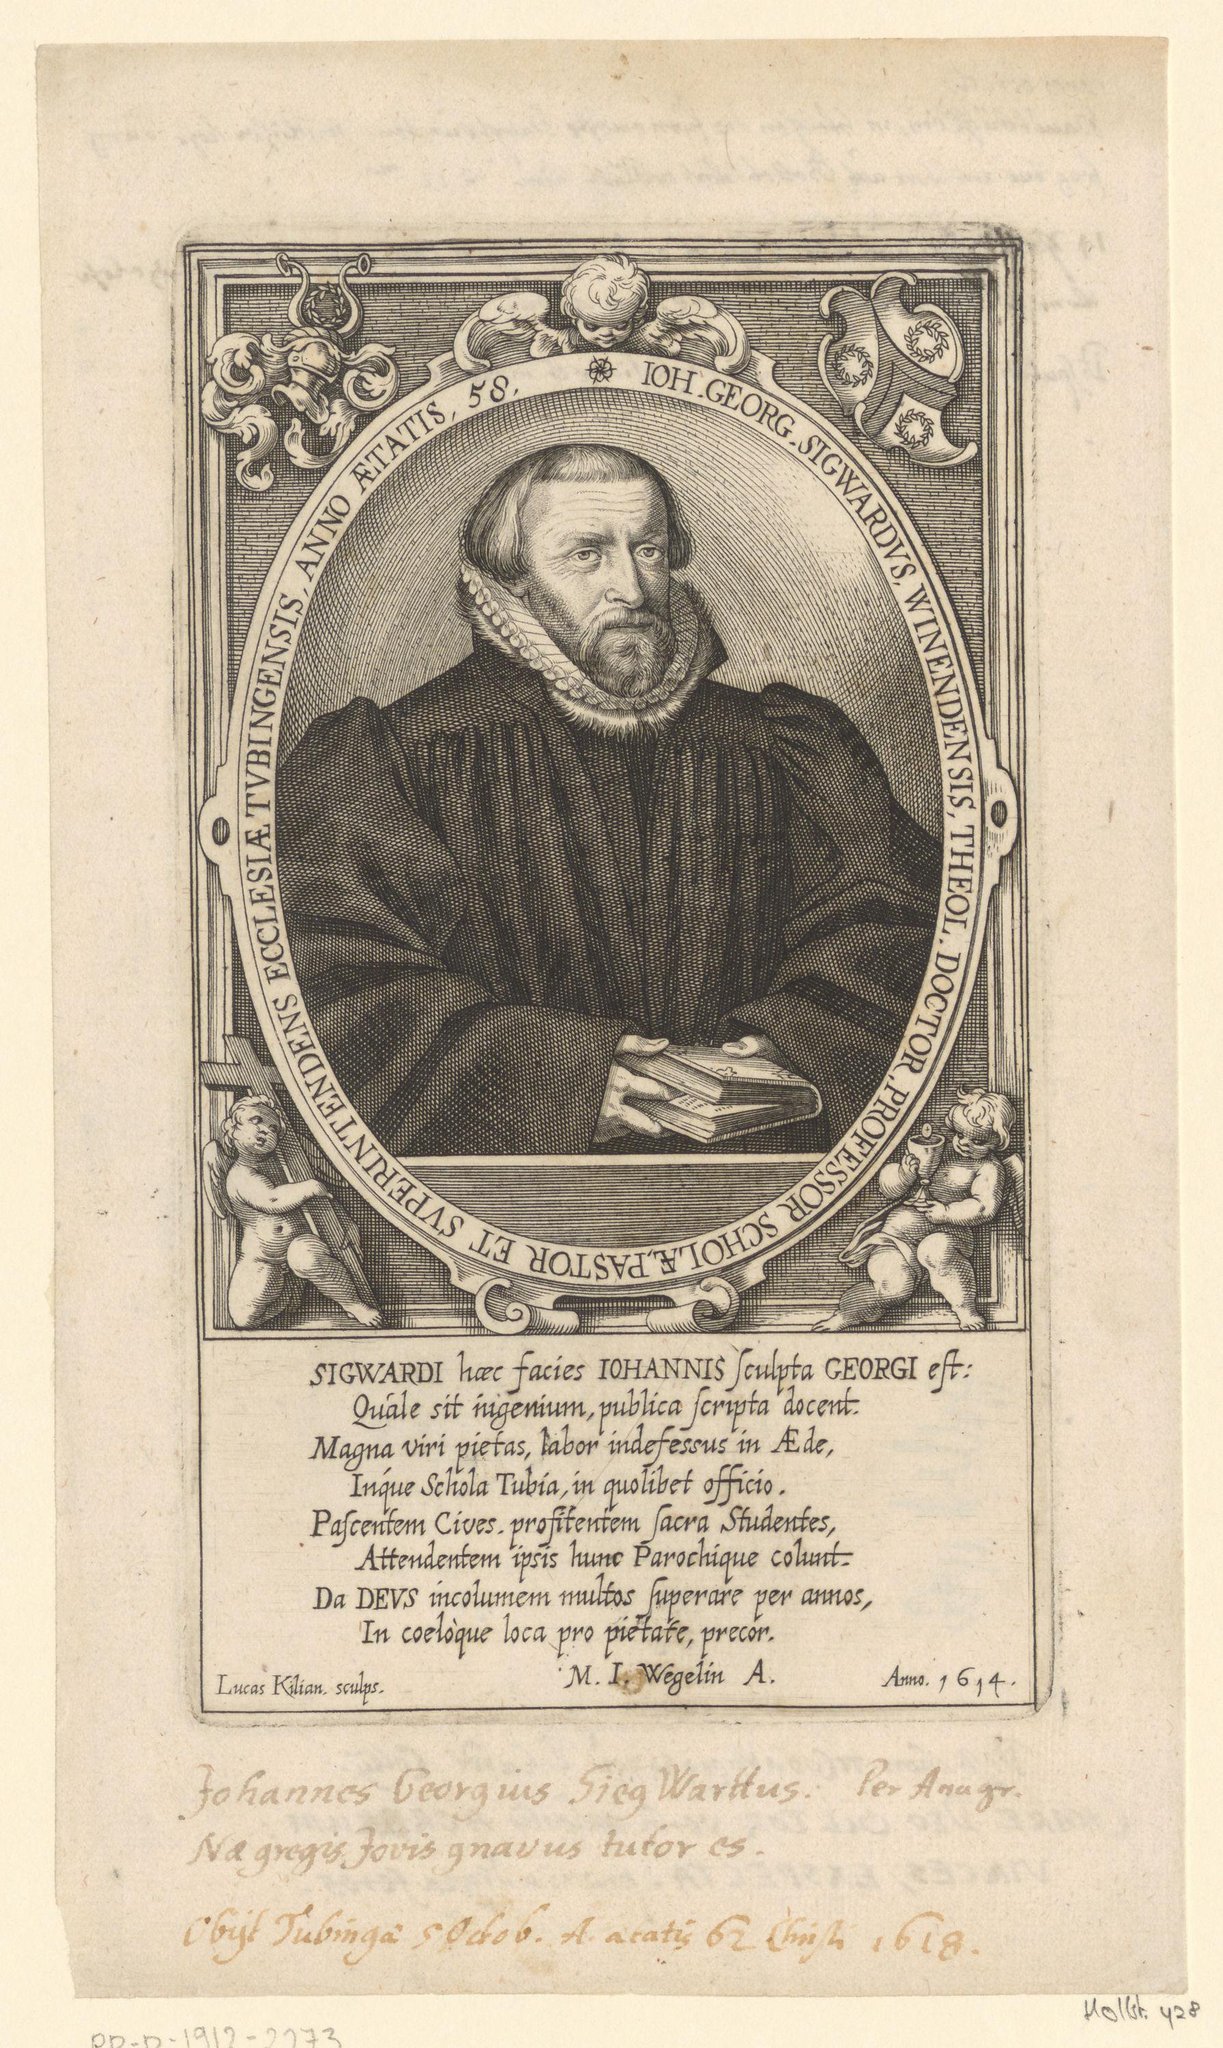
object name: print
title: Portret van Johann Georg Sigwart op 58-jarige leeftijd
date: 1614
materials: paper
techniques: engraving, etching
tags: theologian, further education (+ portrait of teacher, professor), historical persons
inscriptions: annotation: ‘Johannes Georgius Siegwarttus (...) 1618.’, annotation: ‘Libros (...) feros.’, collector's mark: Lugt 2228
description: Tekst in het Latijn in de omlijsting en in de ondermarge.